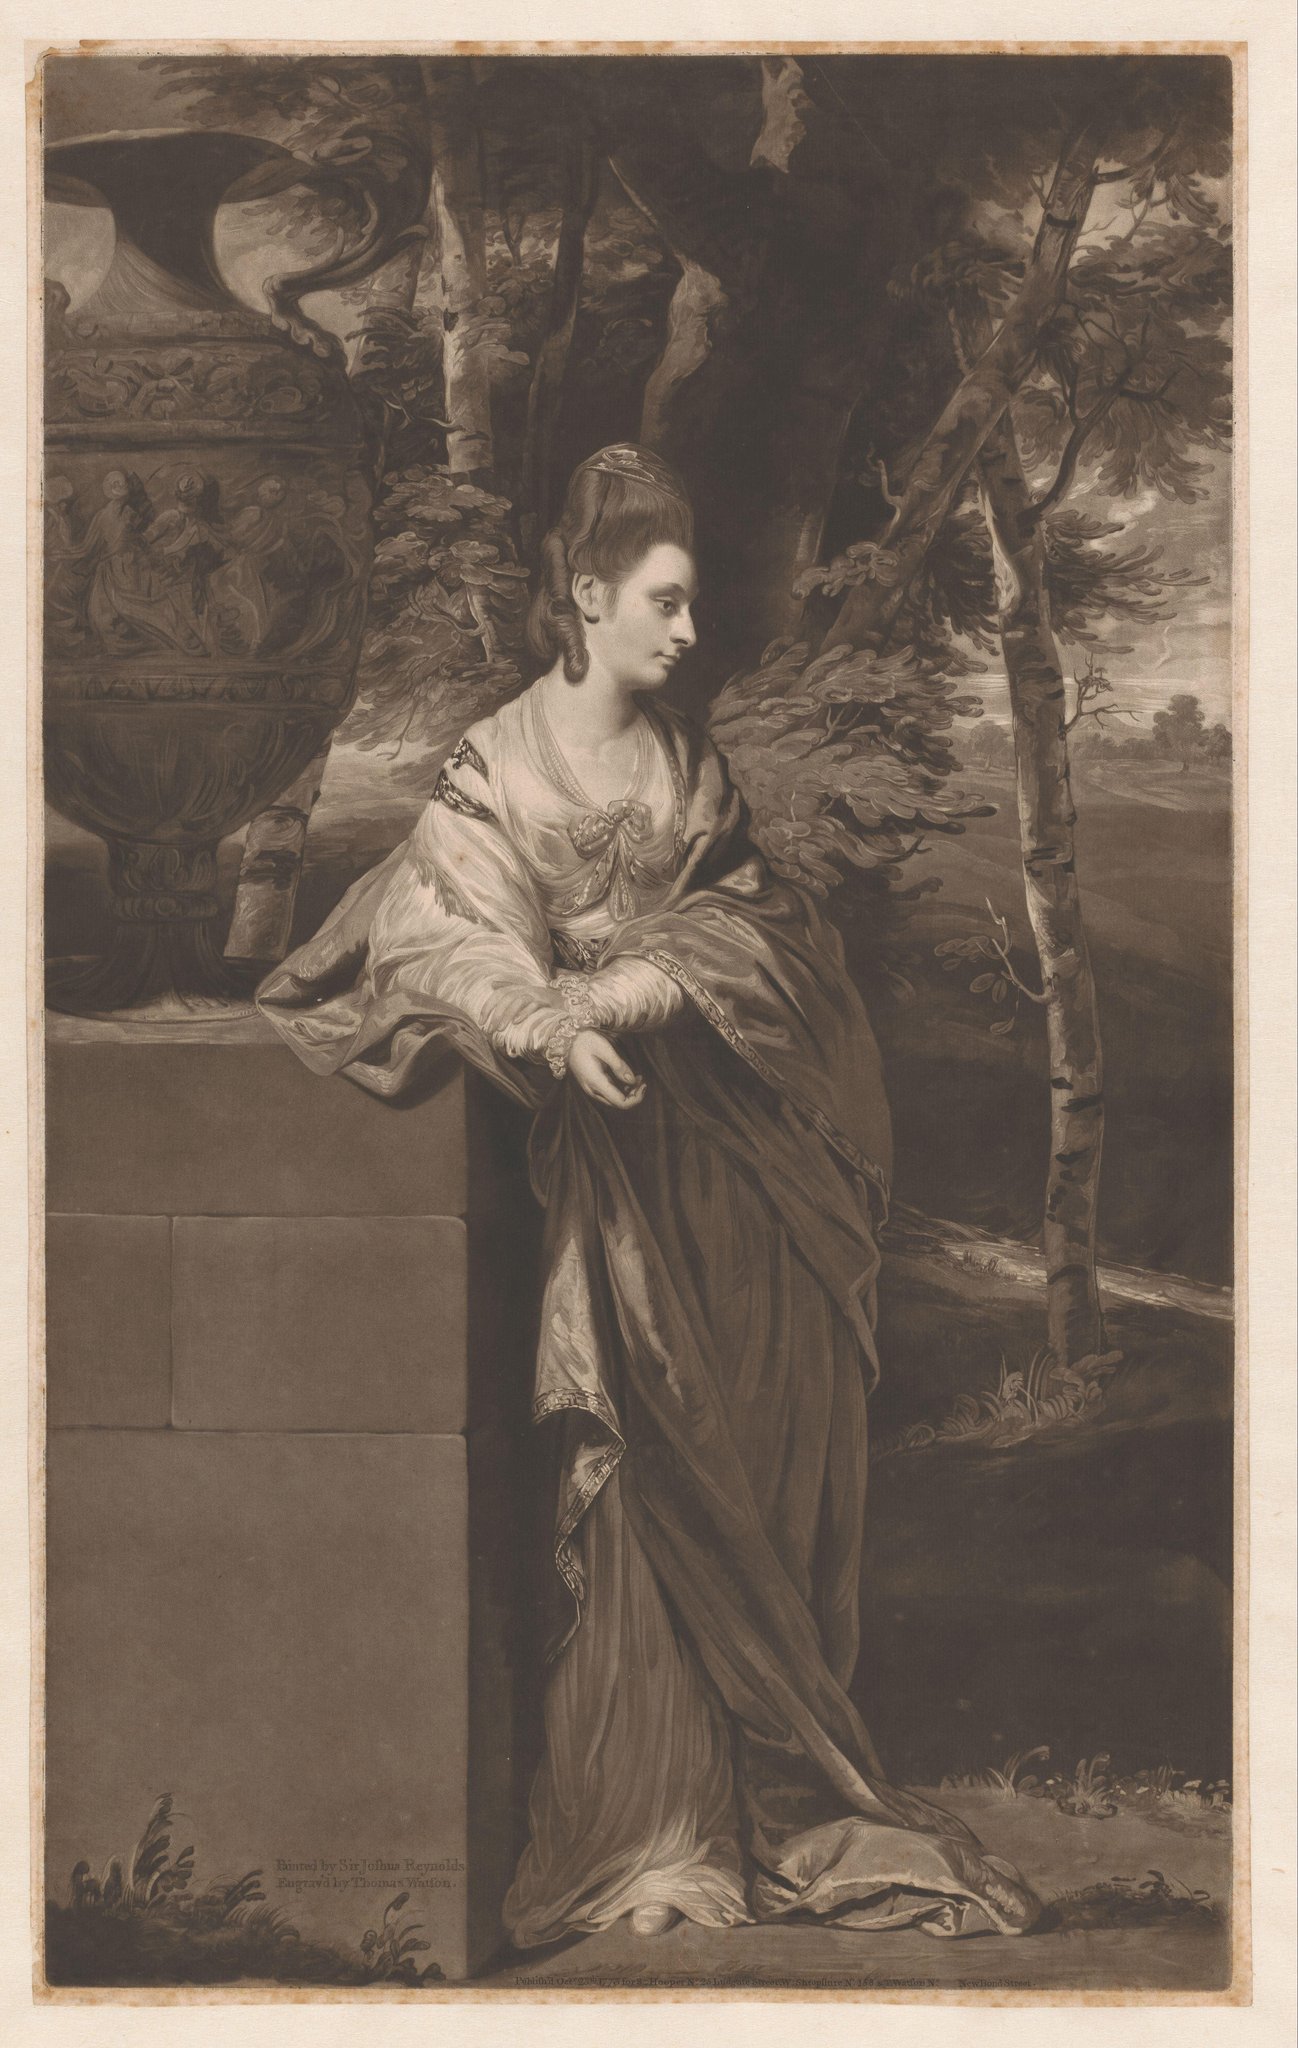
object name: print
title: Portret van Theresa Parker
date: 1710-1773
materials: paper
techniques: mezzotint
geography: london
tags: print maker, theresa parker, historical persons - bb - woman, garden vase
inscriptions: collector's mark: Lugt 240